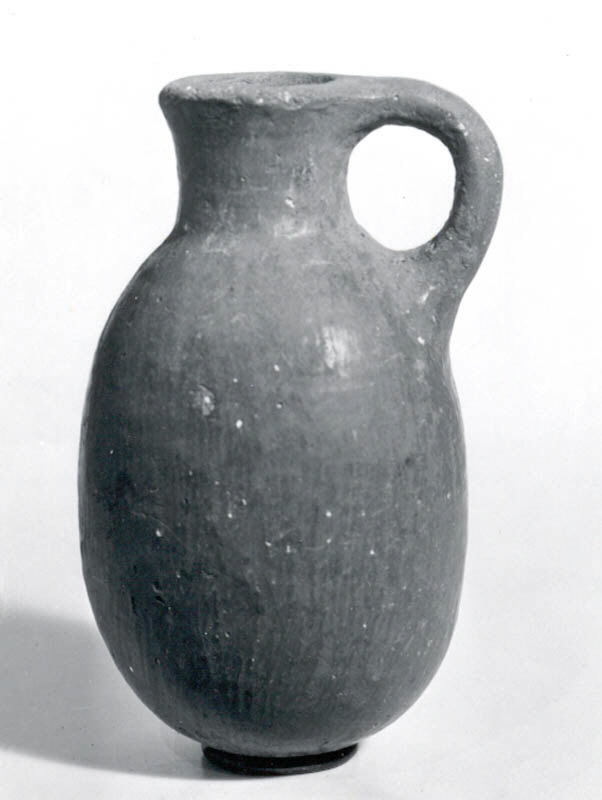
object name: jug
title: Oil jug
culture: israelite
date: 734-601 BCE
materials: ceramic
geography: levant